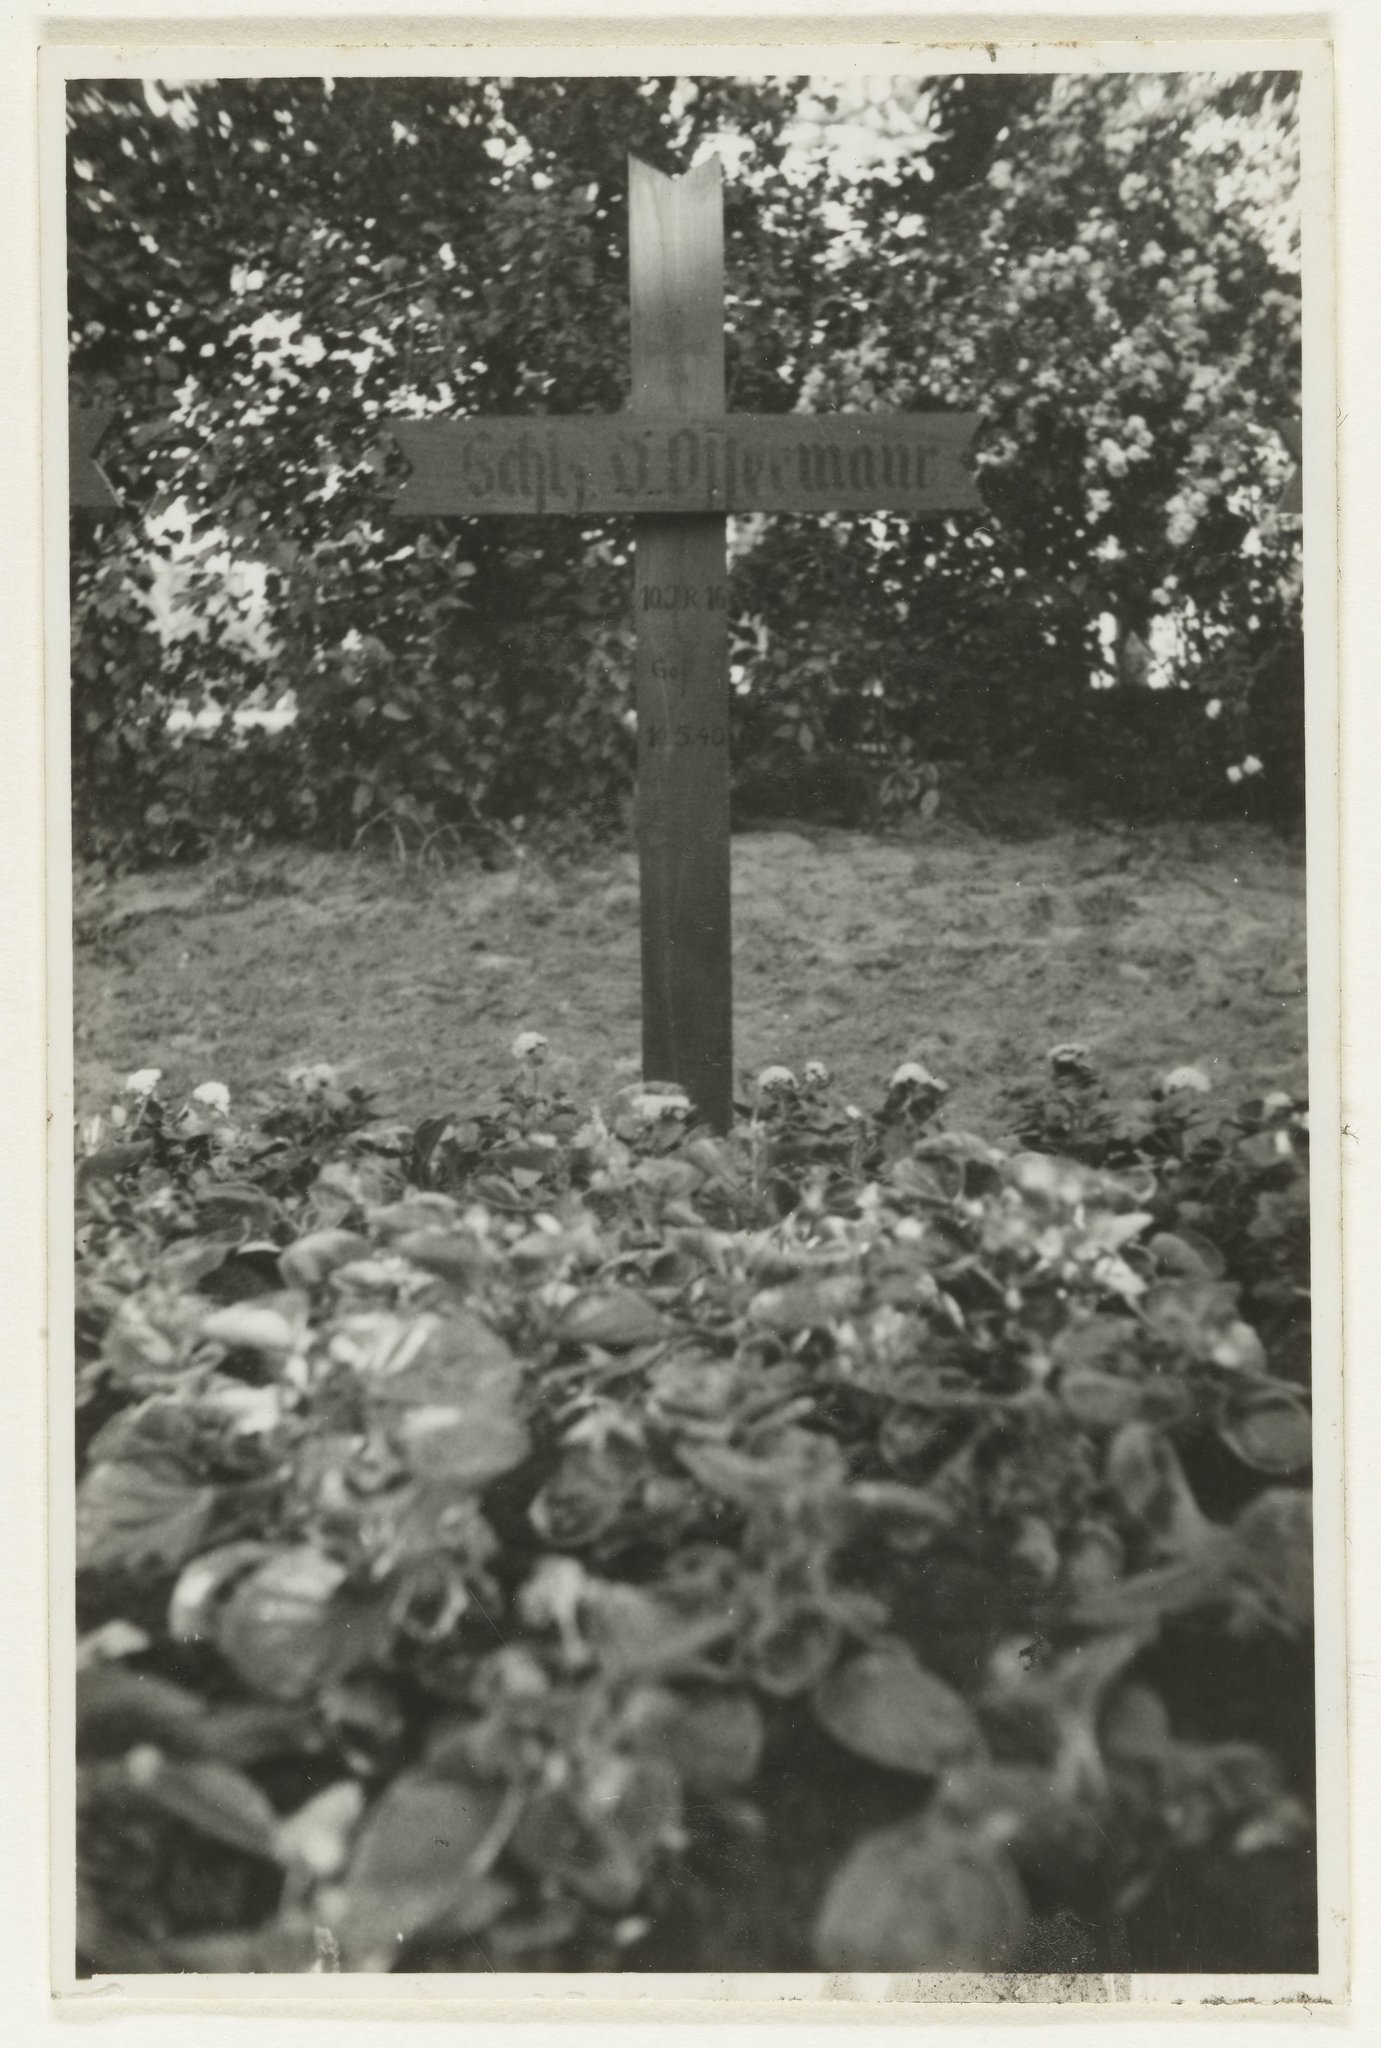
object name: photograph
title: Begraafplaats Duitse militairen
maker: Anonymous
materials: photographic support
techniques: gelatin silver print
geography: rotterdam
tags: churchyard, cemetery, occupation ~ war, grave, tomb and other grave-forms and grave-markers, rotterdam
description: Een begraafplaats met Duitse militairen, Crooswijk. Een houten kruis met naam, geboortedatum en sterfdatum: 10.5.1940